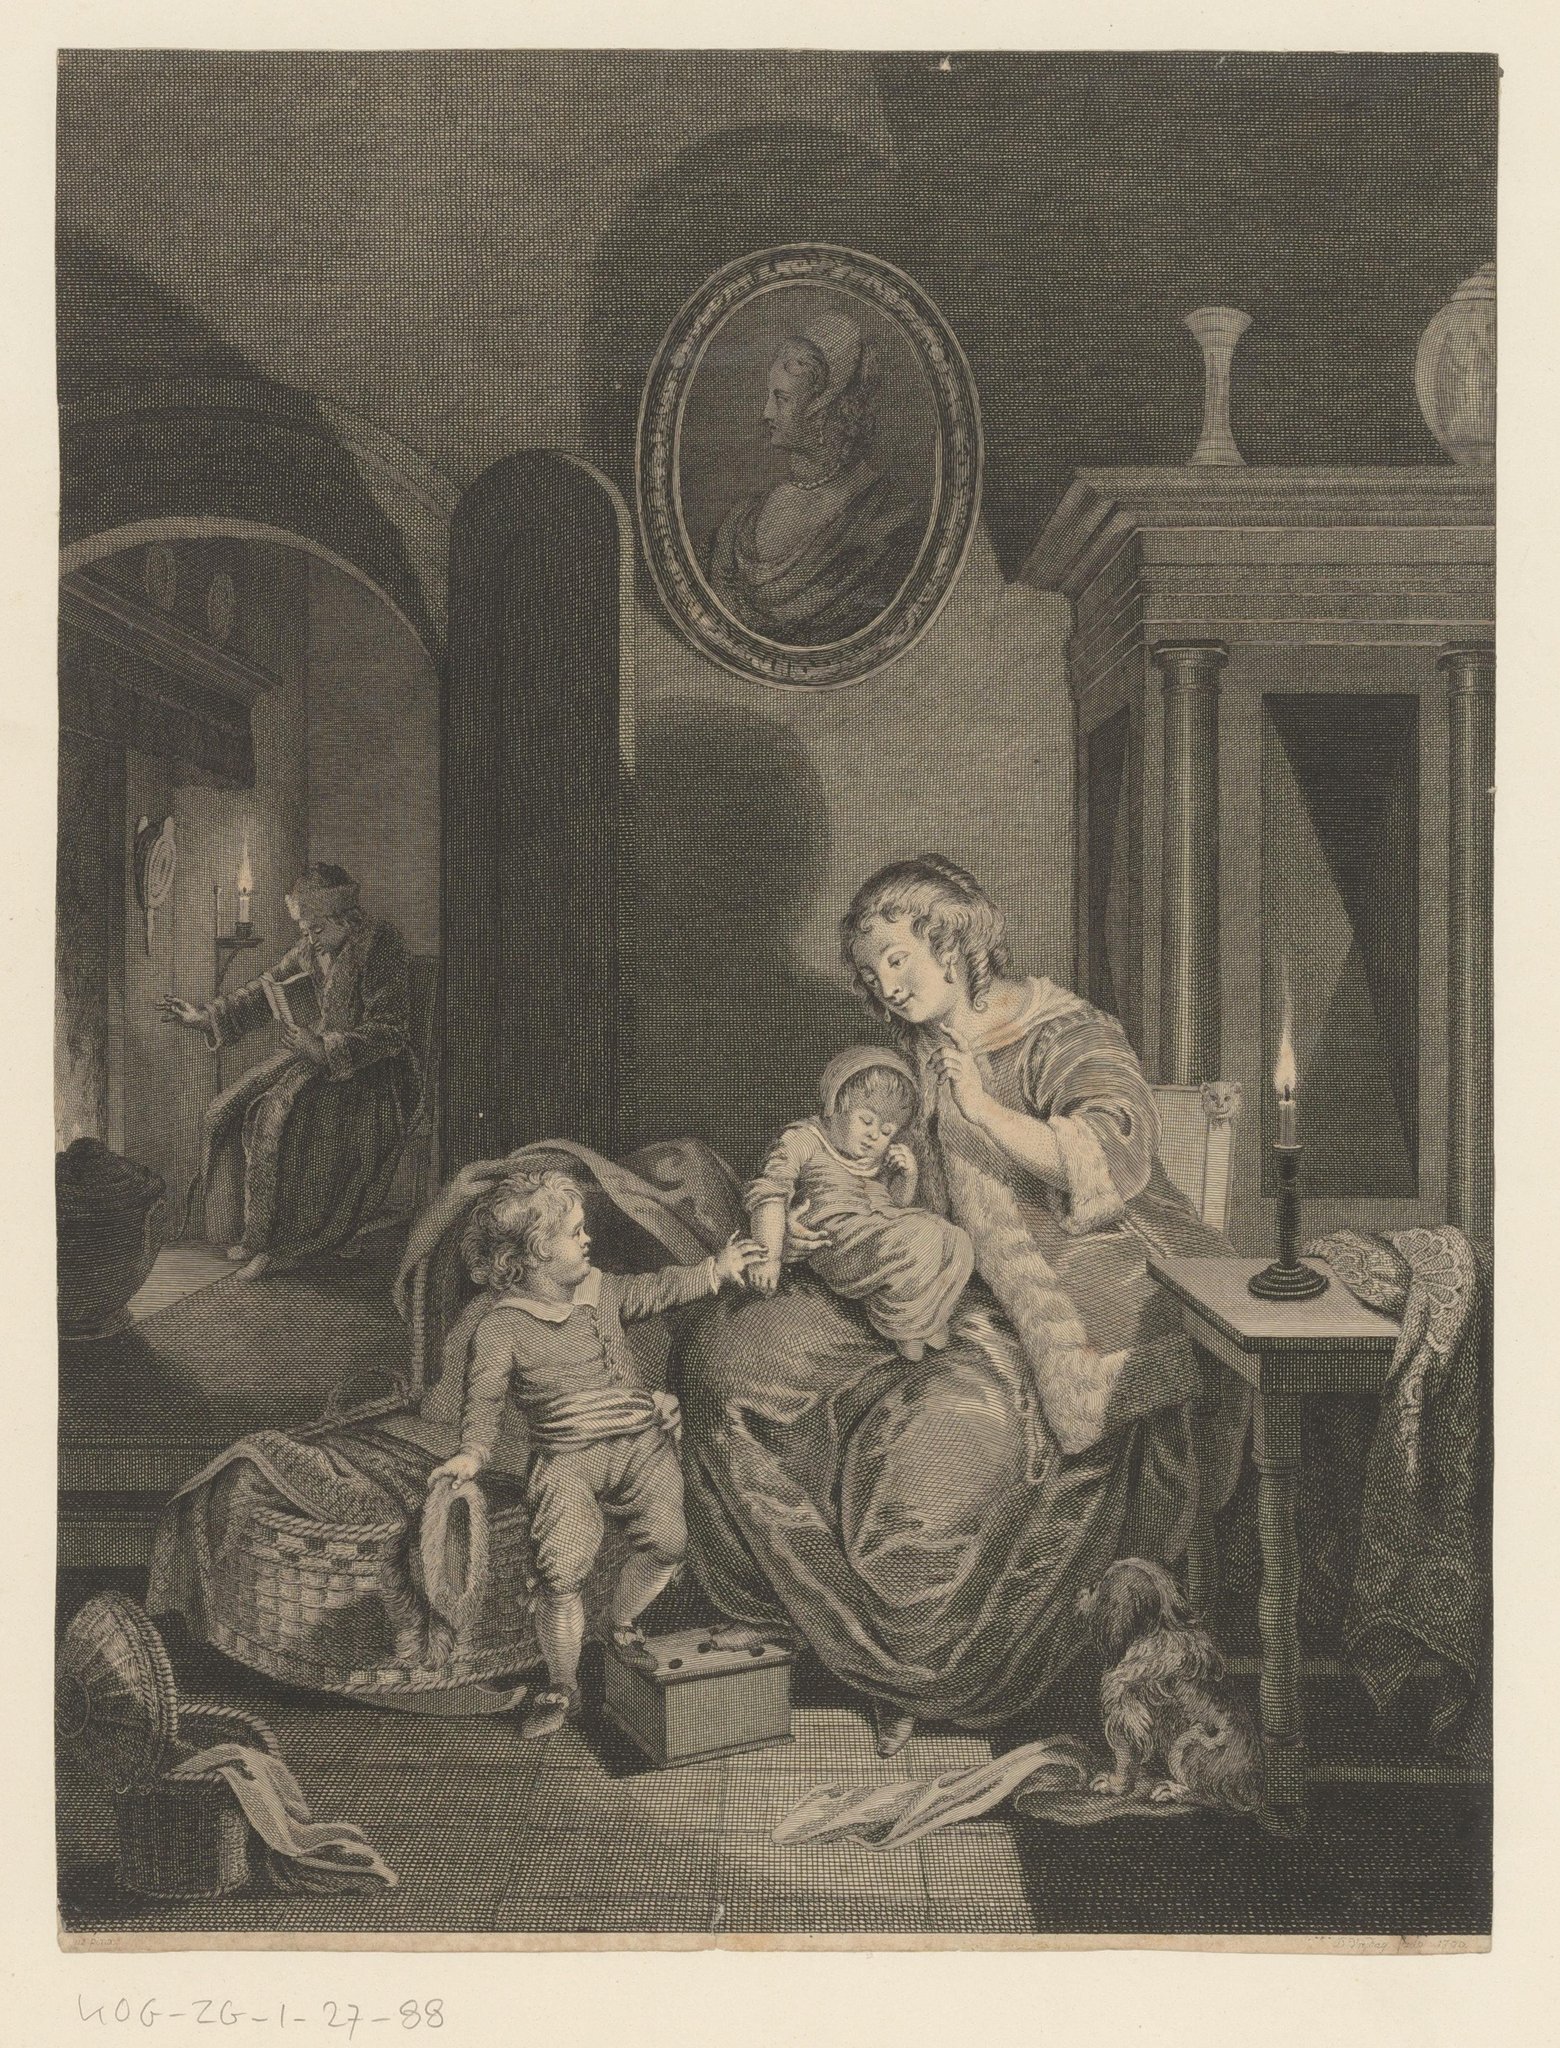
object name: print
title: Jong gezin in de avond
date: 1775-1822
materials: paper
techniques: engraving, etching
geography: netherlands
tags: interior of the house, cradle, crib, family life at home, going to bed, dog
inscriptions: collector's mark, collector's mark: Lugt 1641